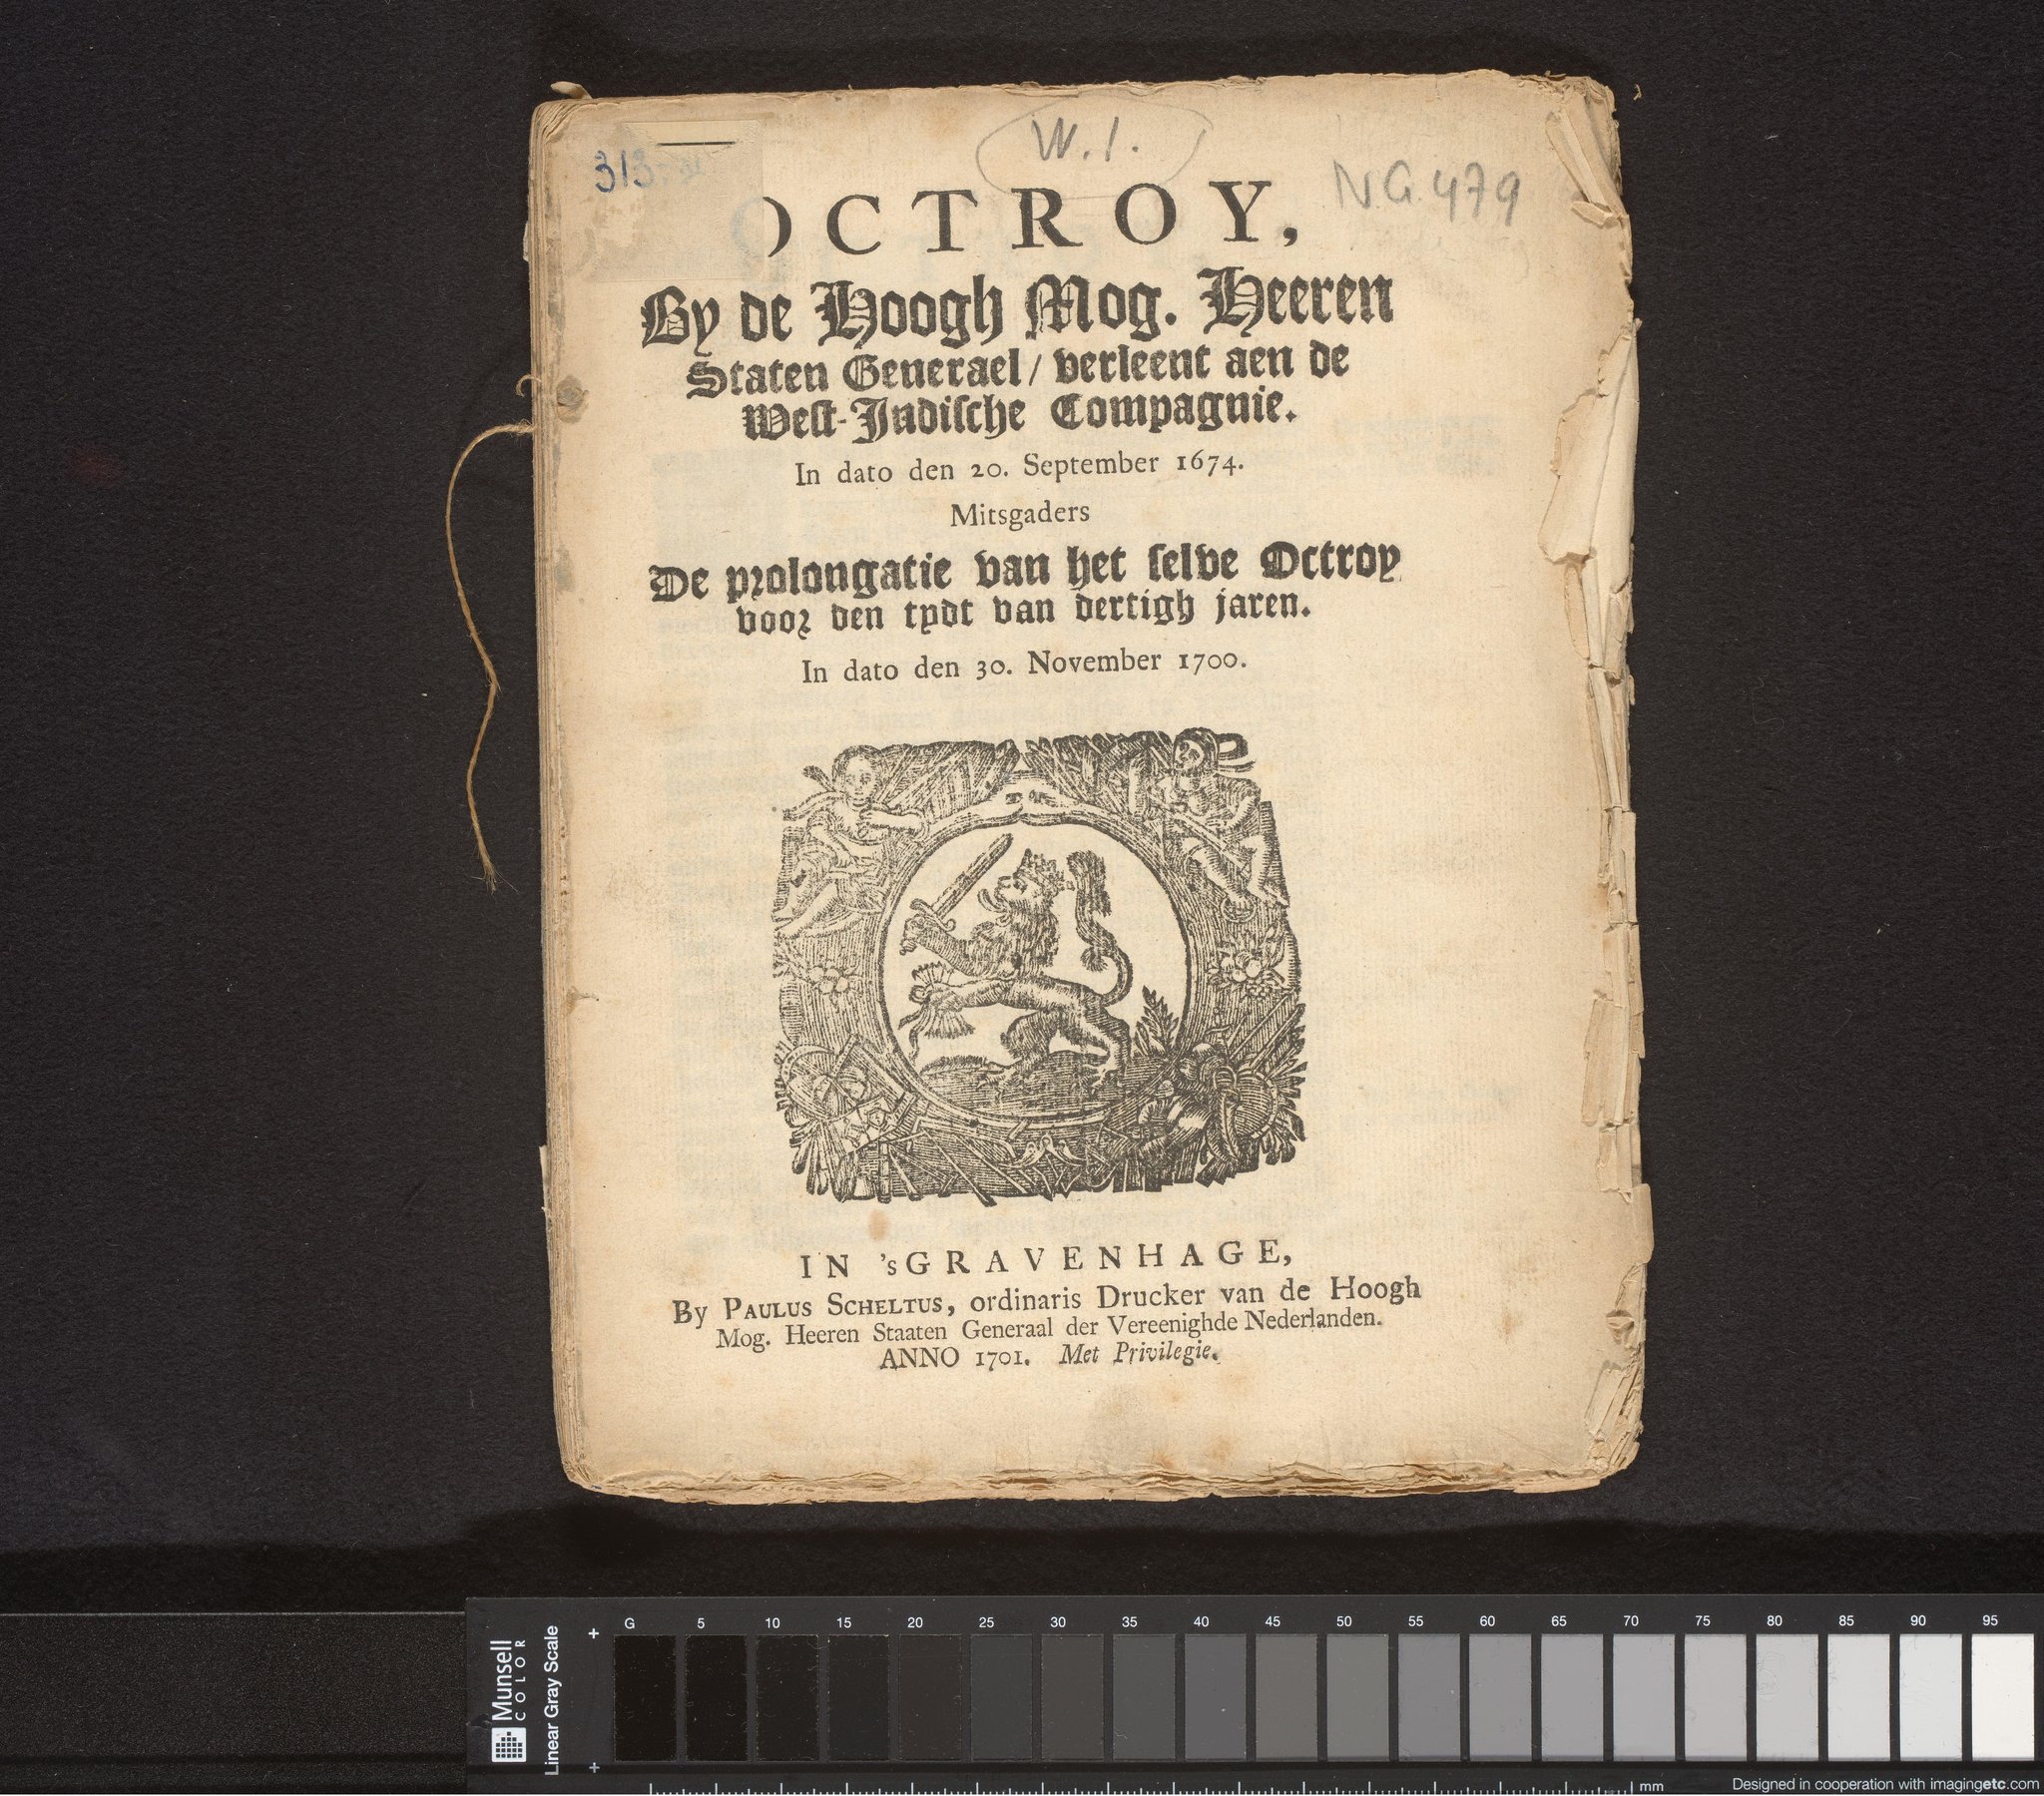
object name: book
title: Octroy, by de Hoogh Mog. Heeren Staten Generael verleent aen de West-Indische Compagnie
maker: paulus scheltus (i)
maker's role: publisher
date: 1701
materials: paper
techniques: printing, sewing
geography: the hague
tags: west-indische compagnie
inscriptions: date